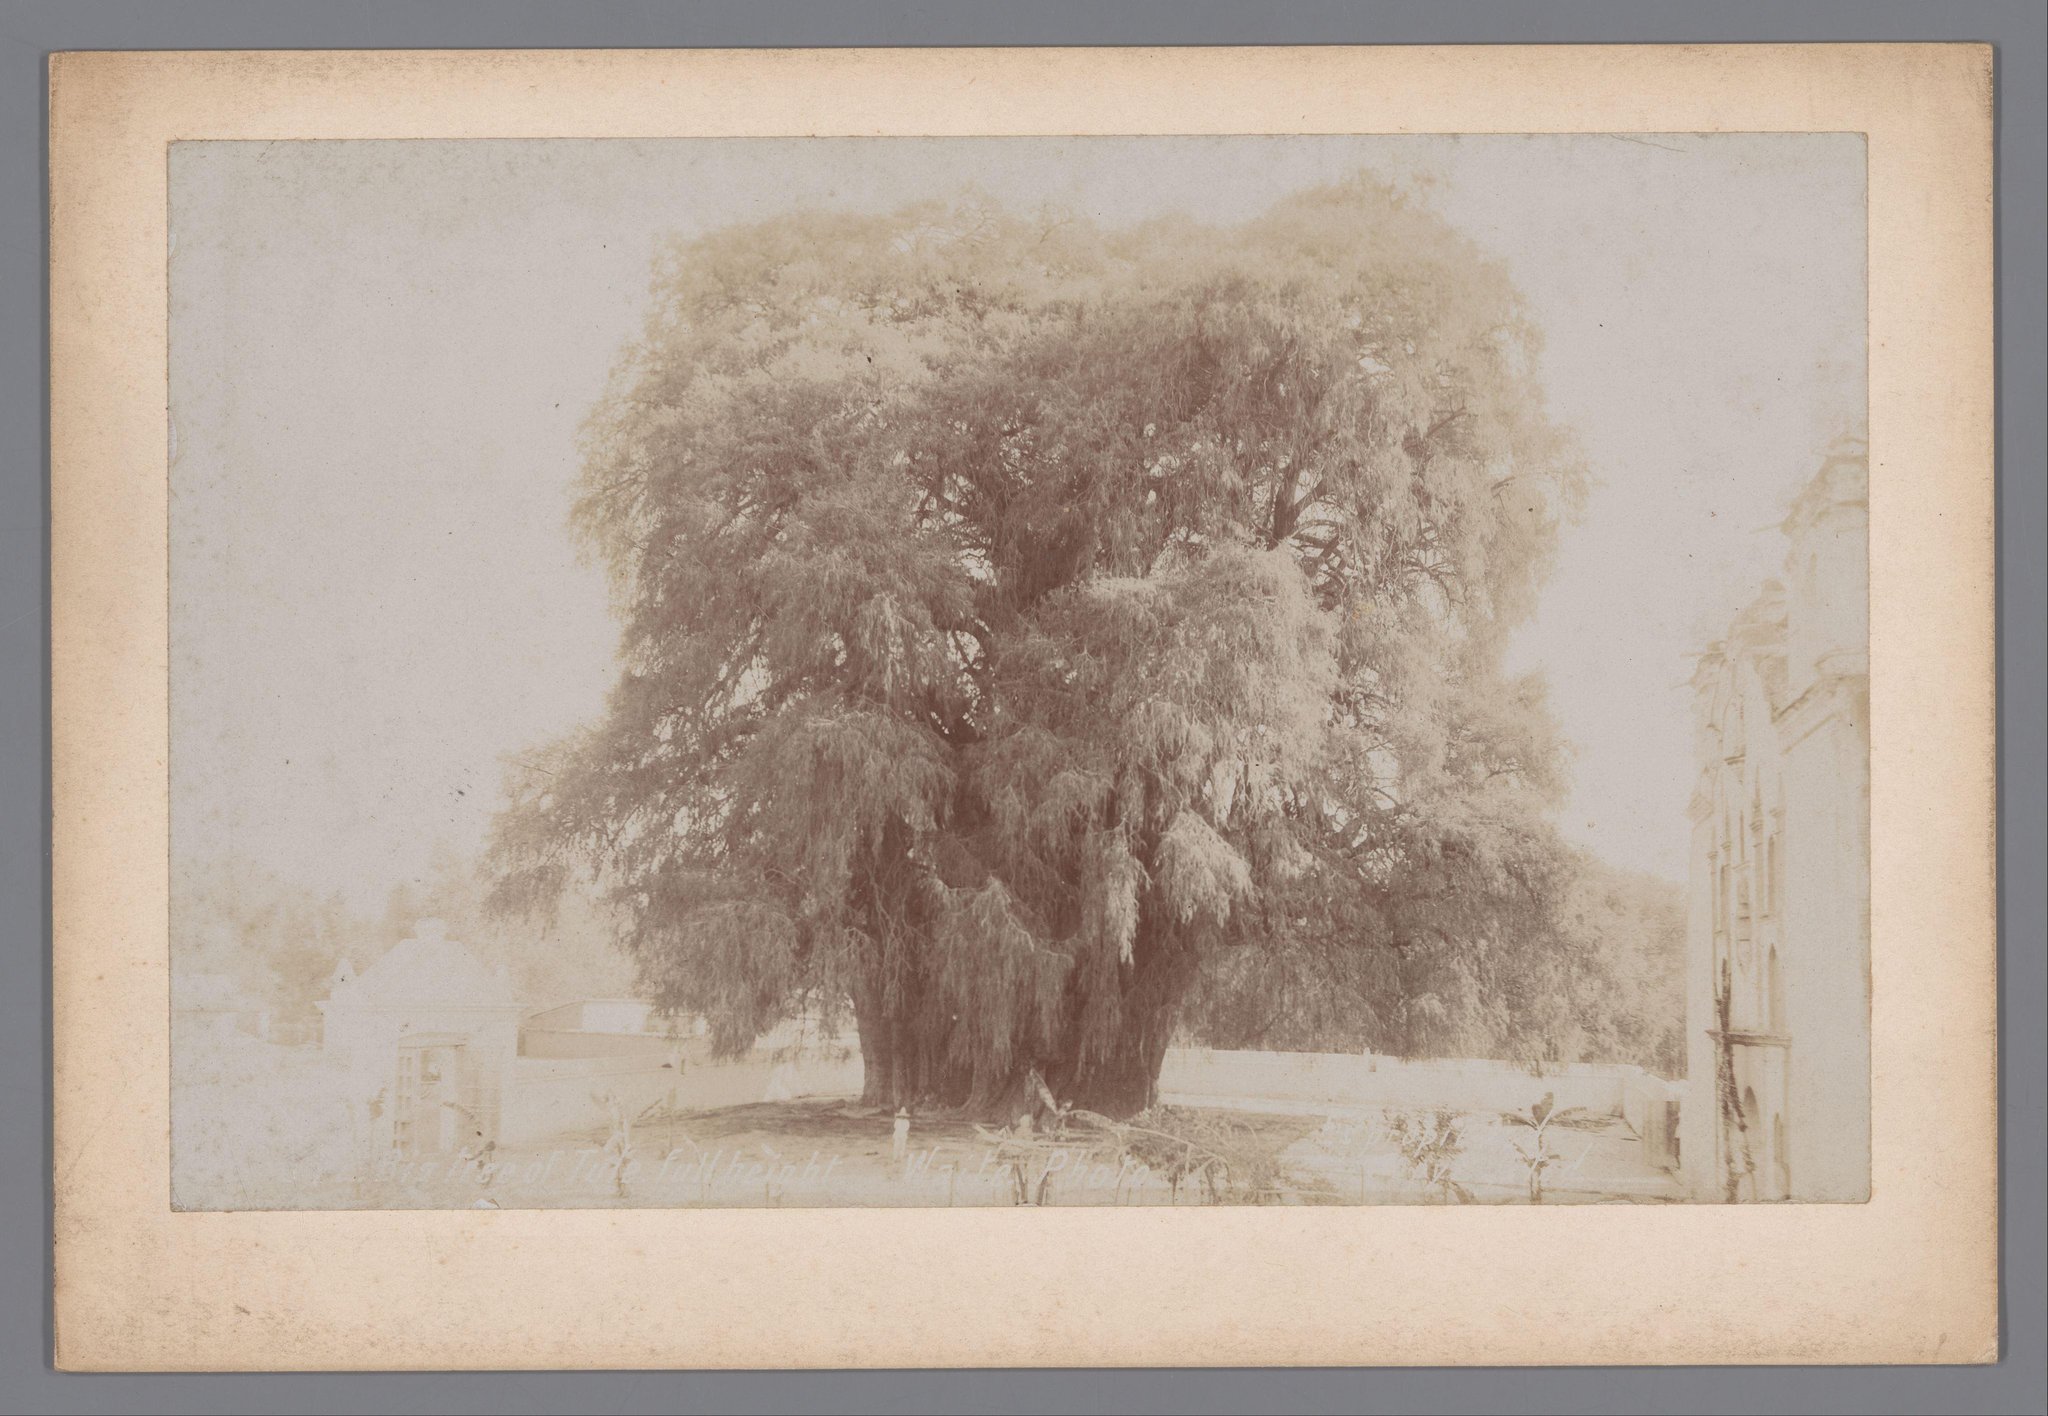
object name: photograph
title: Big Tree of Tule, full height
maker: charles betts waite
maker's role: fotograaf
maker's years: 1861-1927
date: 1897-1923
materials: paper, cardboard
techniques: gelatin silver print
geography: santa maría del tule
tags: trees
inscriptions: copyright notice: ‘Es propiedad/ Copyrighted.’